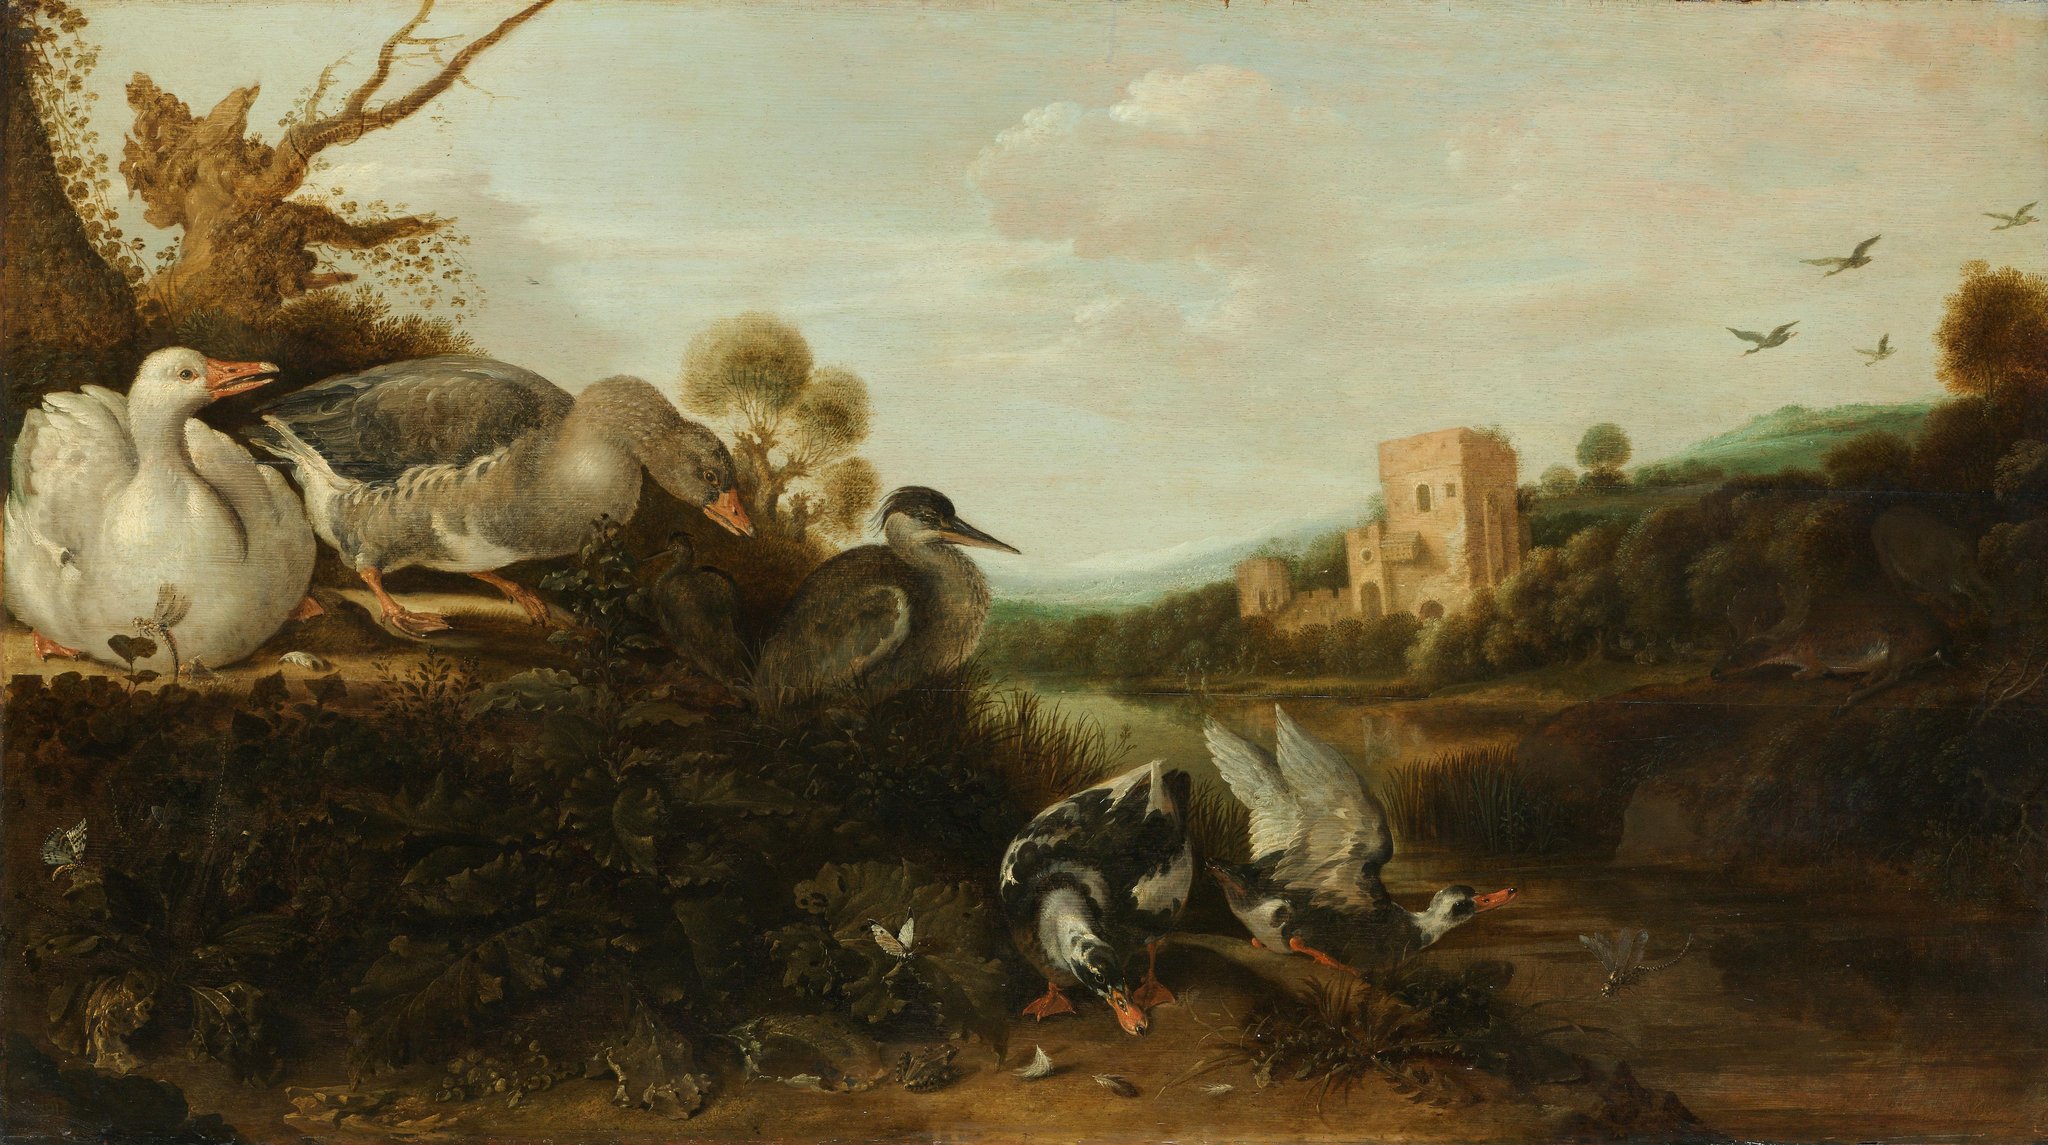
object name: painting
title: Waterfowl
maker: gijsbert gillisz de hondecoeter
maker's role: painter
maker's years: 1604-1653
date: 1652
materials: oil, panel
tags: water-birds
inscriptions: signature and date, lower left: ‘GDH 1652’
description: Watervogels. Een groepje ganzen, eenden en een reiger bij de waterkant. Tussen het gebladerte op de voorgrond zit een kikker en vliegen vlinders en libellen. Op de achtergrond een rivierlandschap met een vervallen toren.